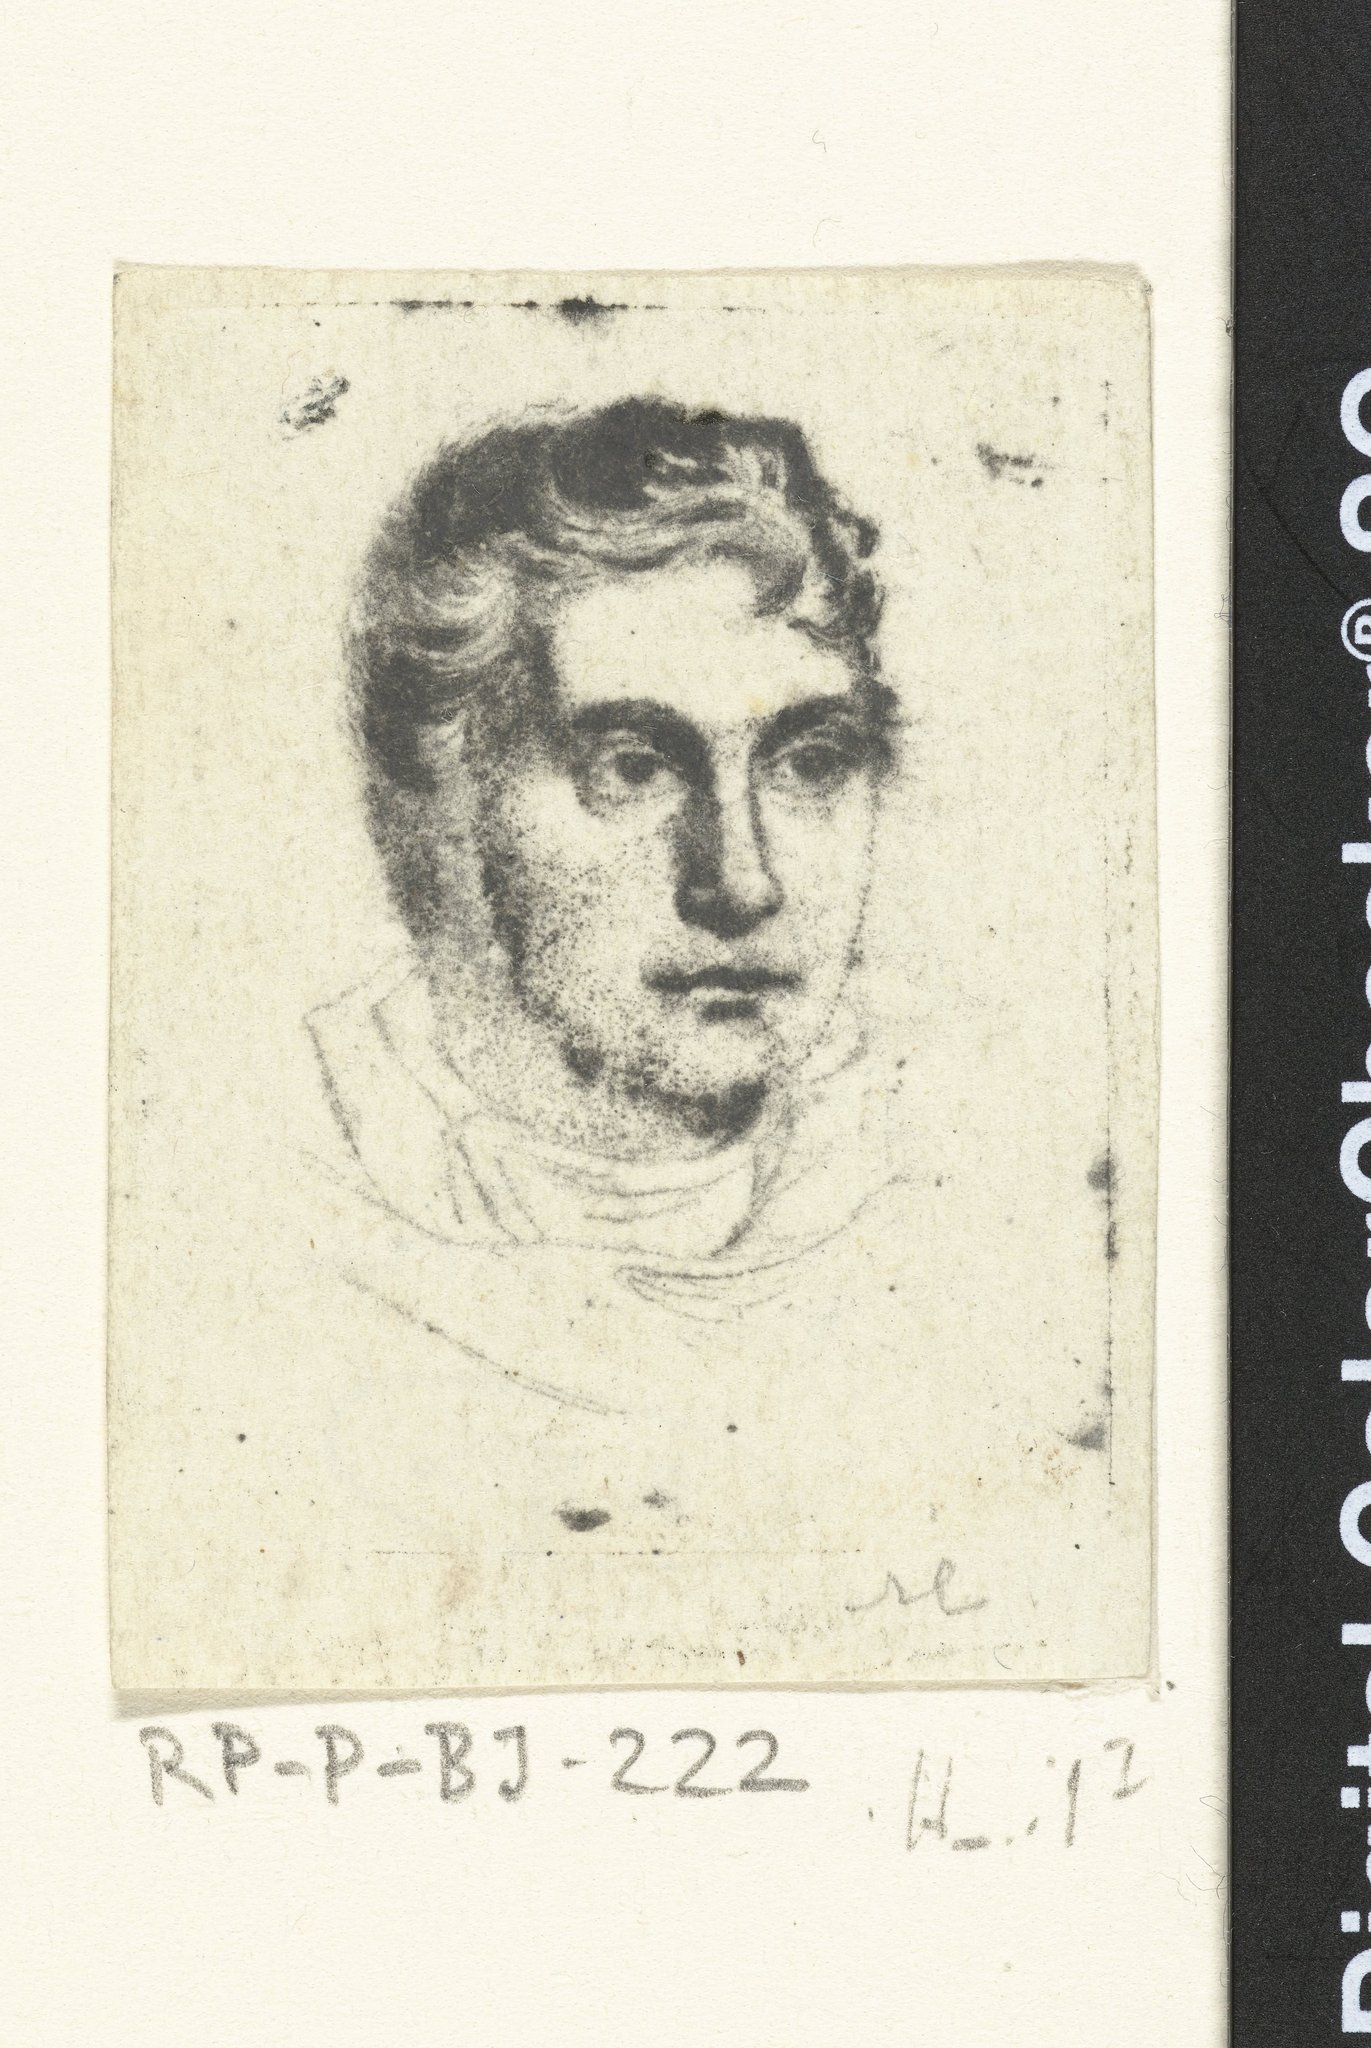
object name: print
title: Portretbuste van Ernst Willem Jan Bagelaar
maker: ernst willem jan bagelaar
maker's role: draughtsman, print maker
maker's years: 1775-1837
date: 1798-1837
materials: paper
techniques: etching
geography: netherlands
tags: ernst willem jan bagelaar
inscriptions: collector's mark: Lugt 2228